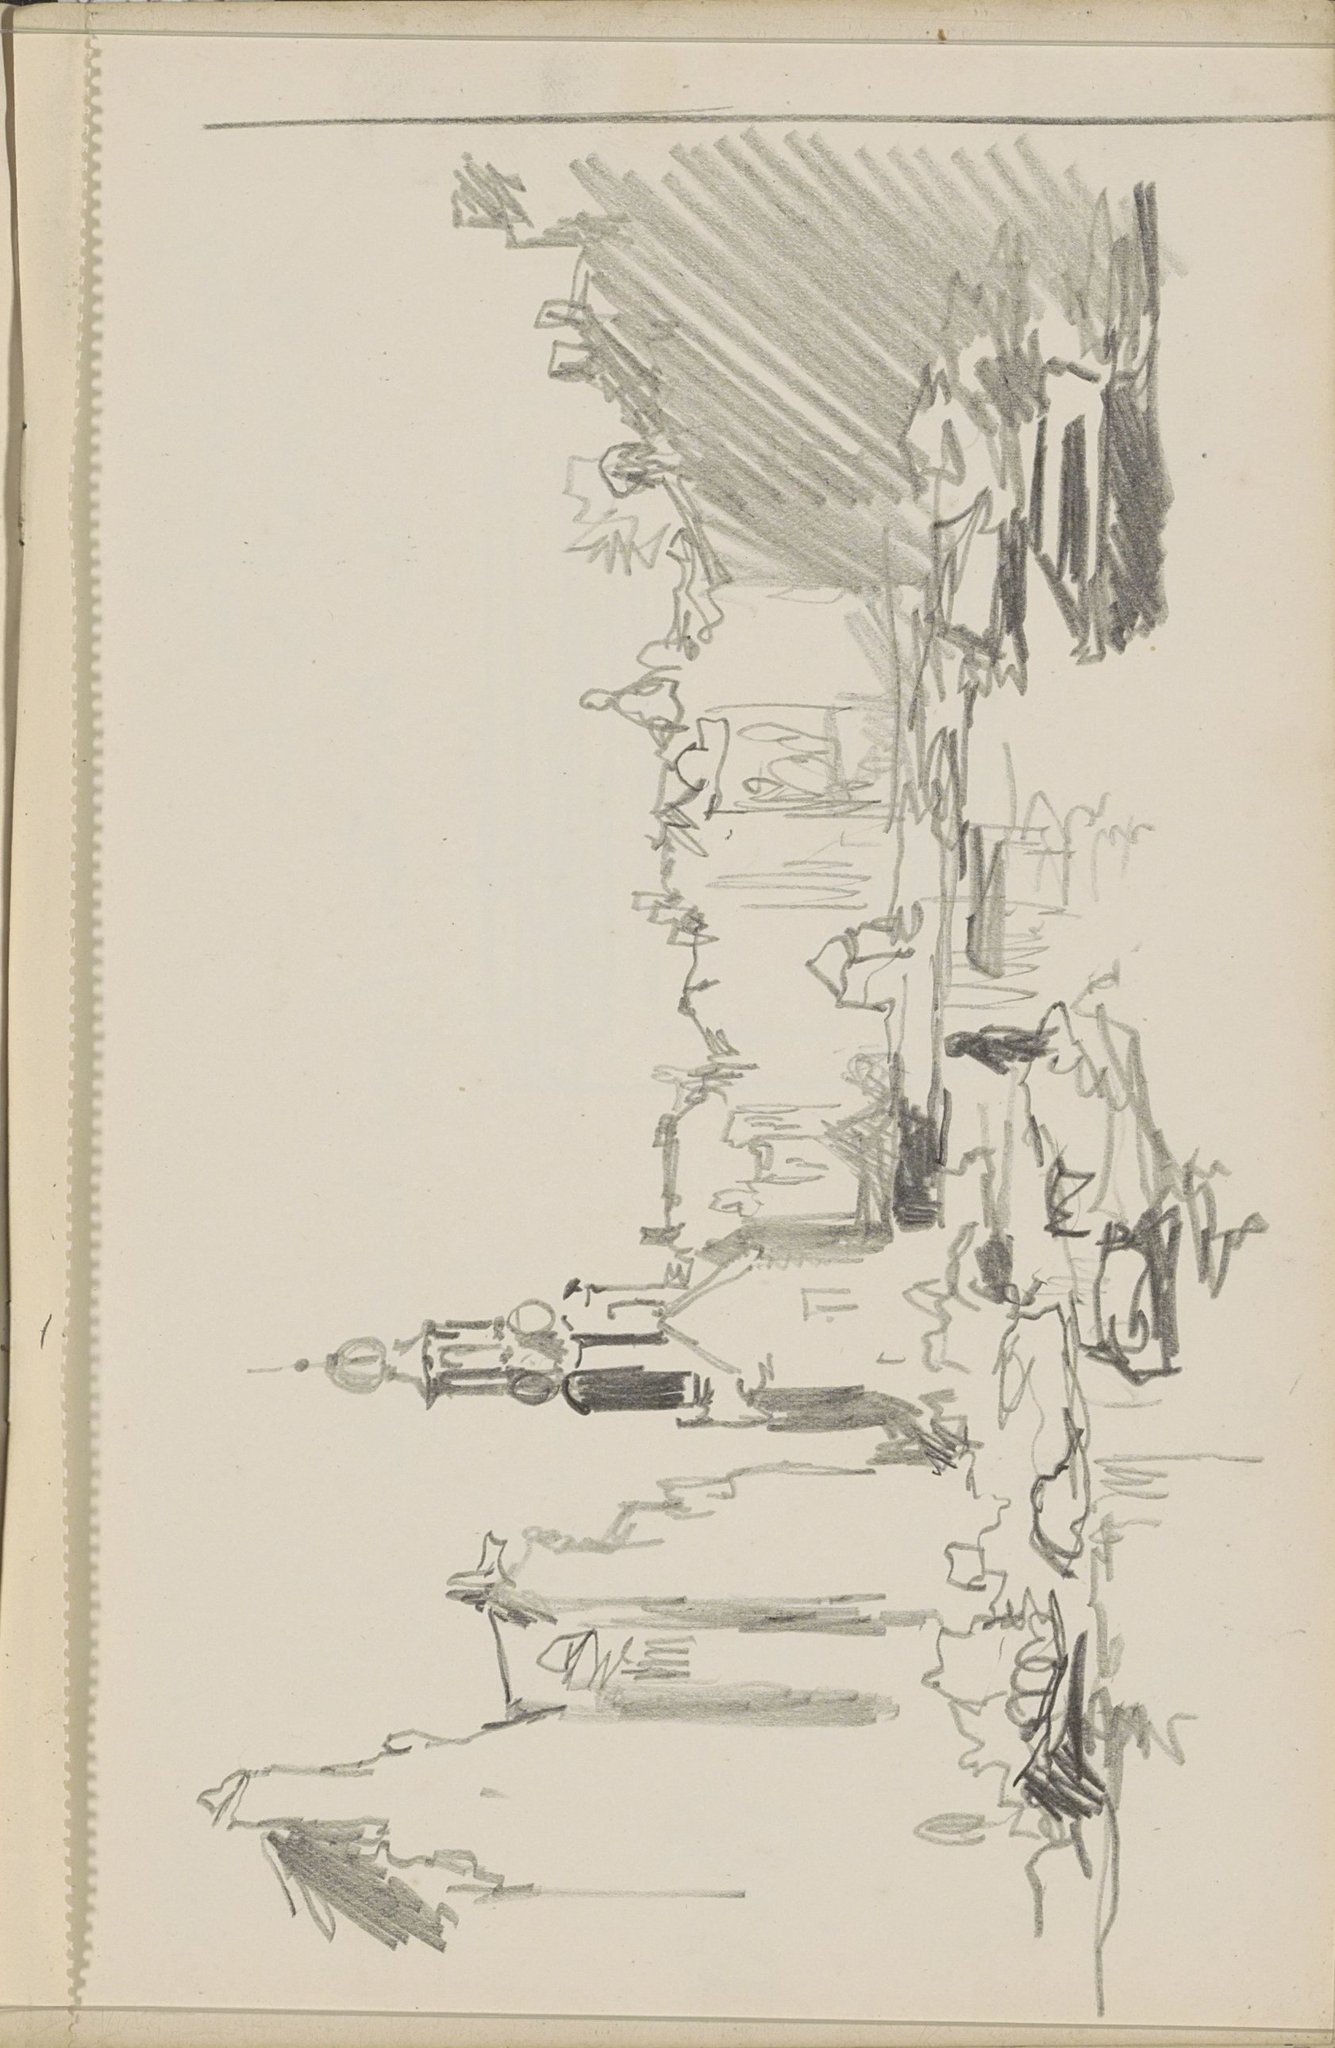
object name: sketchbook leaf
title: Boten op een gracht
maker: cornelis vreedenburgh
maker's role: draughtsman, print maker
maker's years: 1880-1946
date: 1890-1946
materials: paper, pencil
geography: amsterdam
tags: canals, waters (in city)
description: Op de achtergrond een kerktoren. Blad 42 recto uit een schetsboek met 59 bladen.